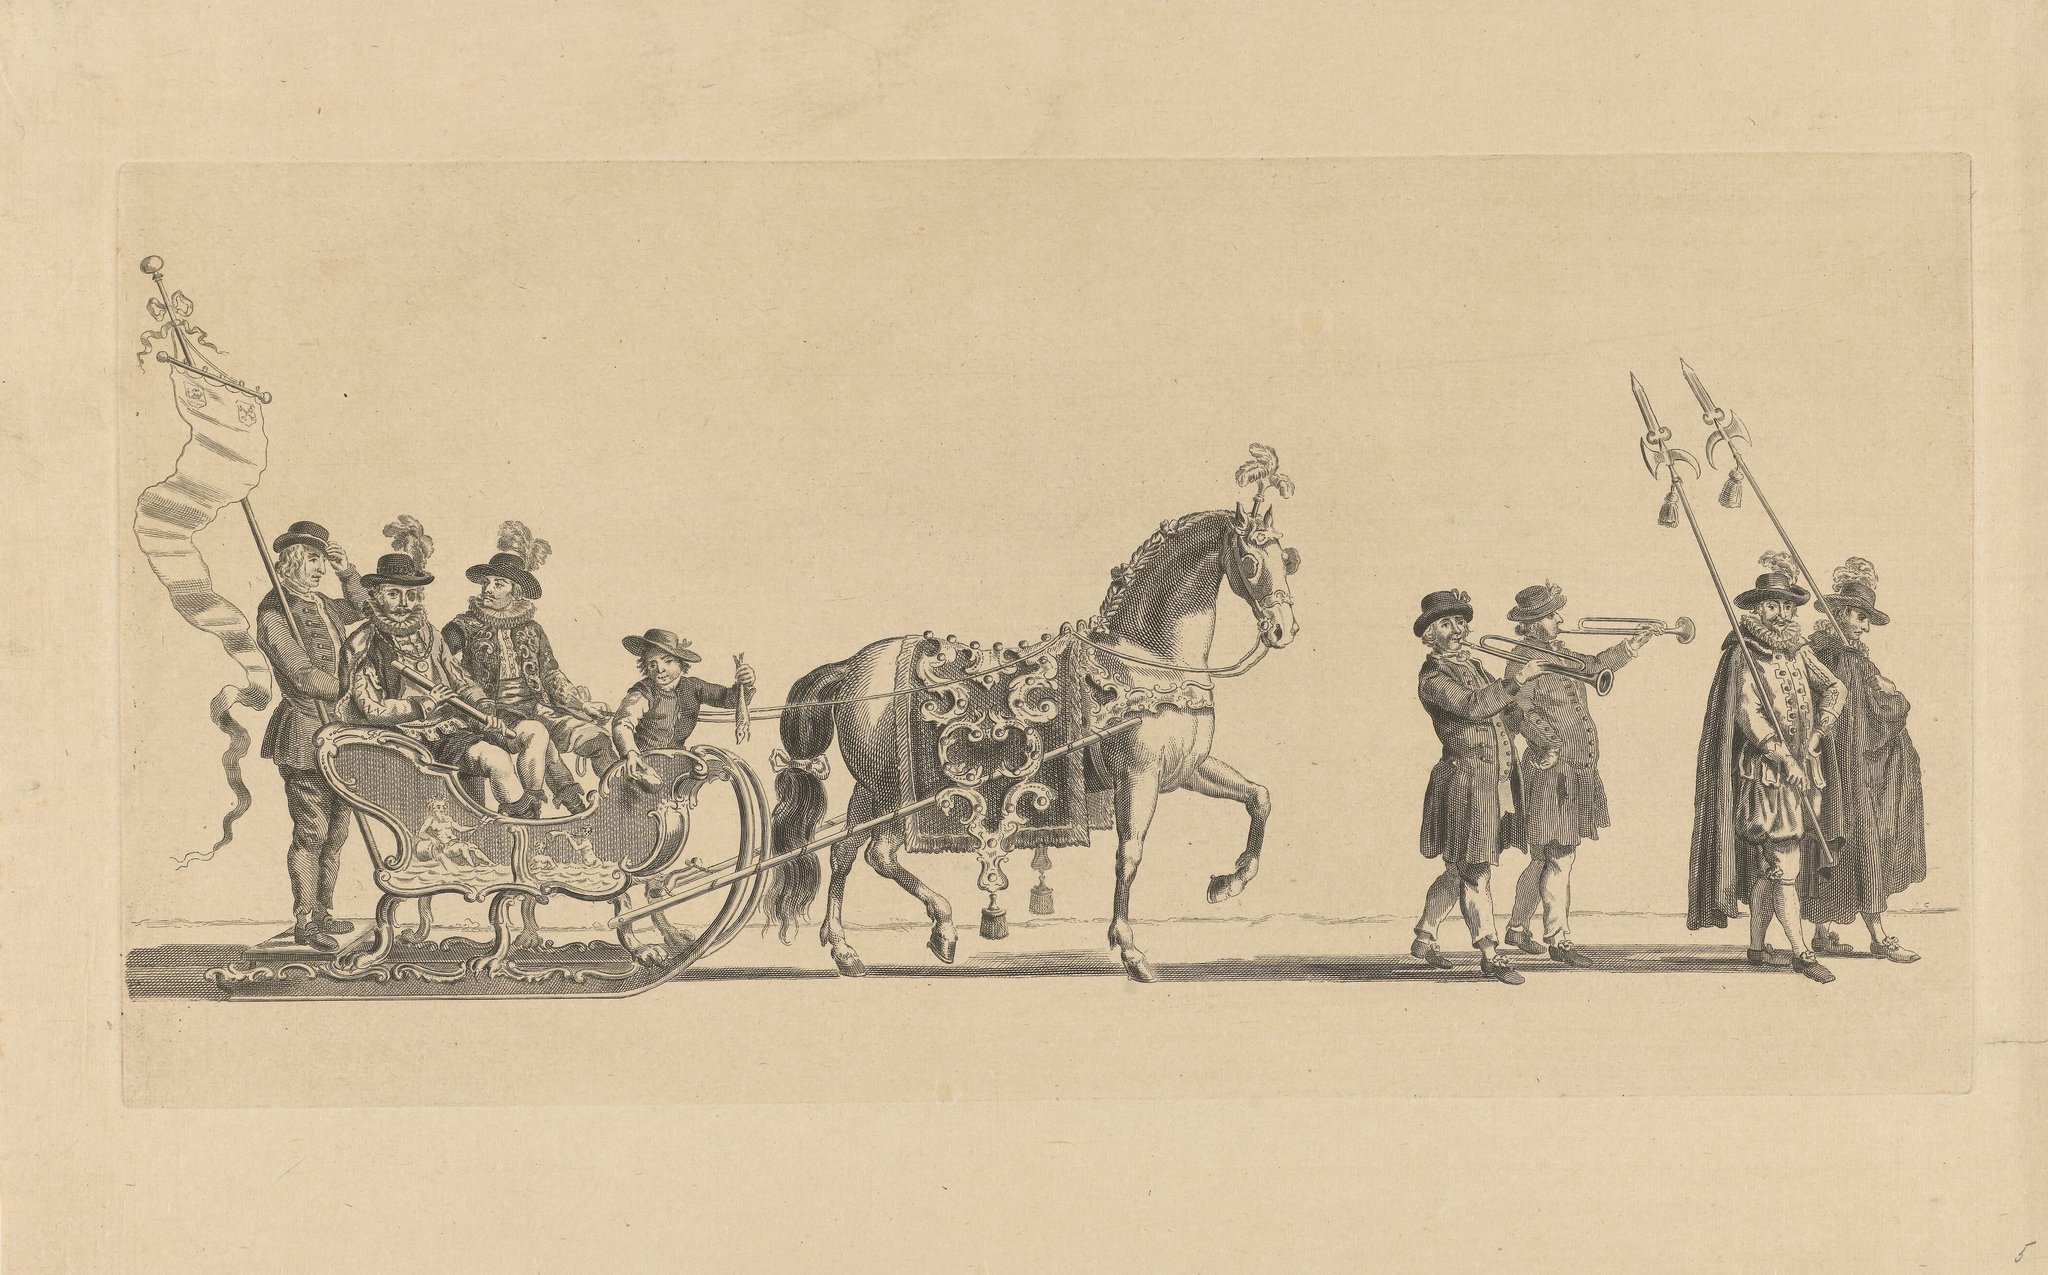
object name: print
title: Vijfde slede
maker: nicolaas van der worm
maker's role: draughtsman, print maker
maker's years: 1757-1828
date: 1776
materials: paper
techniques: engraving, etching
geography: northern netherlands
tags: brussels, sledge, sleigh (winter sports), commemoration of the founding of a university, leiden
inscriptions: collector's mark: Lugt 240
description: De vijfde slede in de optocht. Een slede met Louis de Boisot en een jongen met witbrood en een haring, getrokken door een paard en voorafgegaan door twee muzikanten en twee hellebaardiers. Onderdeel van een reeks van twaalf platen (vóór het nummer en op ander papier) van de sledevaart op 24 januari 1776 georganiseerd door het Leidse genootschap Veniam Pro Laude bij gelegenheid van het Tweede Eeuwfeest van het Leids Ontzet (3 oktober 1574) en de oprichting van de Universiteit van Leiden (8 februari 1575).